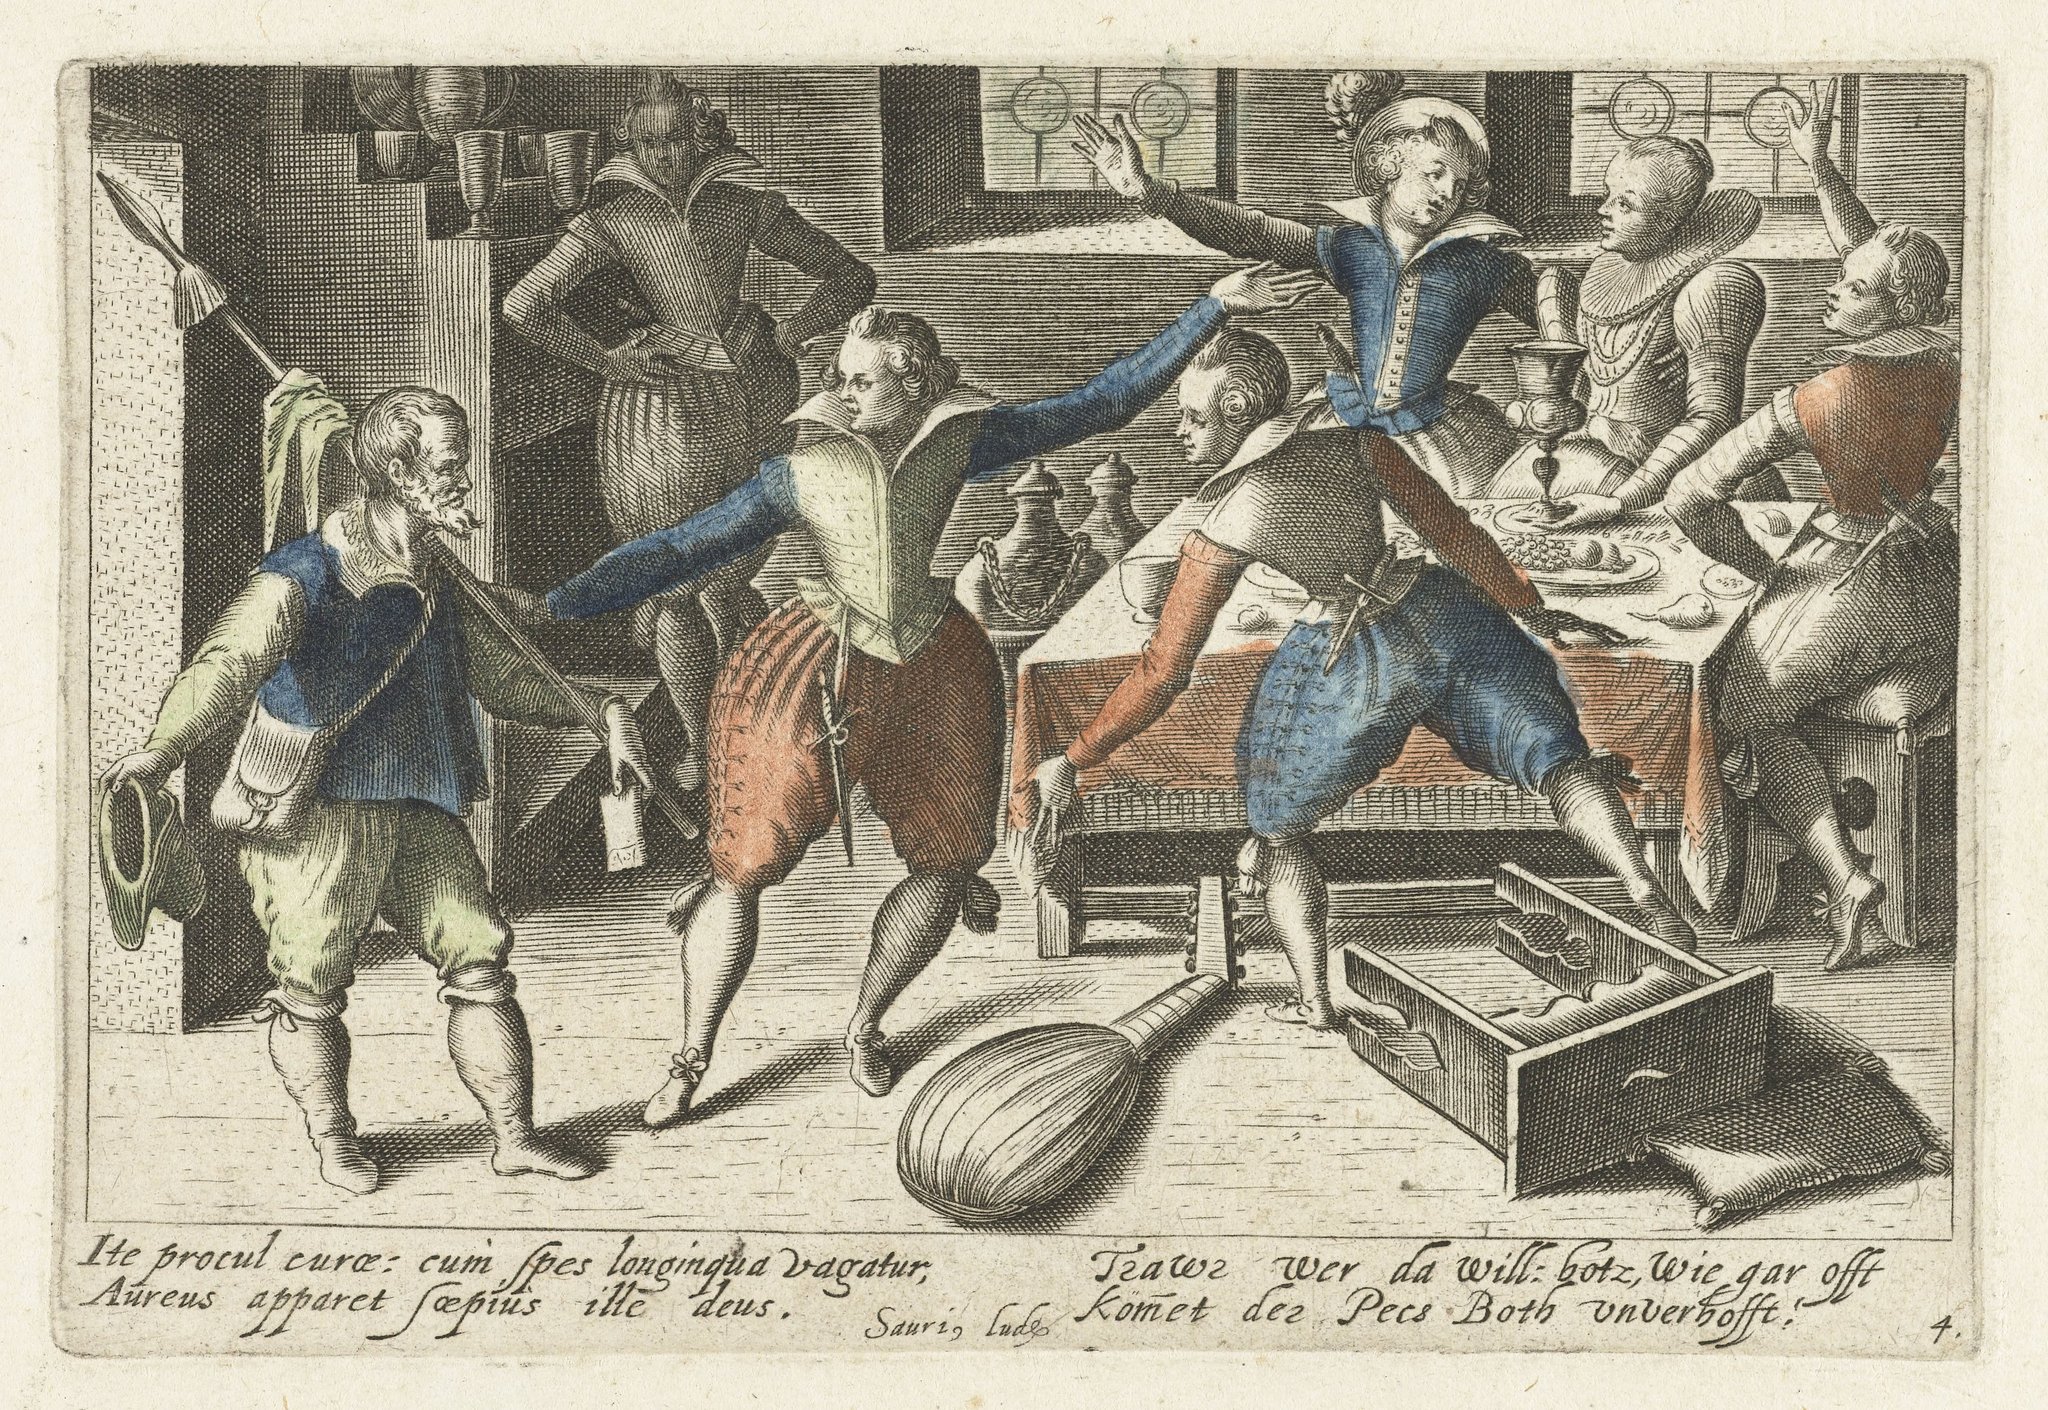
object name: print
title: Pugillus facetiarum iconographicarum in studiosorum (...)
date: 1608-1618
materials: paper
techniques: engraving, etching, hand coloring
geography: straatsburg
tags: 'album amicorum', 'stammbuch', beadle, lute, and special forms of lute, e.g.: theorbo, student life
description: Deze serie, getiteld ‘Pugillus facetiarum iconographicarum in studiosorum (…)’, bestond vermoedelijk uit 36 of meer prenten. Van deze serie zijn in ieder geval twee uitgaven bekend, uit 1608 en 1618. De prenten uit deze serie in de collectie van het Rijksmuseum (RP-P-1996-1 t/m RP-P-1996-36) zijn vermoedelijk afkomstig uit verschillende uitgaven, of uit de tweede uitgave. De inhoud van beide uitgaven verschilt, maar om de precieze inhoud van de verschillende uitgaven vast te stellen is meer onderzoek nodig. Er zijn geen volledige exemplaren van de eerste uitgave bekend. Aan de hand van de analyse van een andere serie, ‘Jeucht spieghel’,* die kopieën van ‘Pugillus’ bevat en is uitgegeven in 1610 én de aanwezige exemplaren van prenten uit ‘Pugillus’ in een inmiddels verloren album amicorum uit 1610,** kan in ieder geval van een aantal prenten gesteld worden dat ze al voorkwamen in de uitgave van 1608. Dit geldt voor RP-P-1996-1 (de titelprent), RP-P-1996-5, RP-P-1996-6, RP-P-1996-7, RP-P-1996-8, RP-P-1996-9, RP-P-1996-10, RP-P-1996-11, RP-P-1996-12, RP-P-1996-13, RP-P-1996-14, RP-P-1996-15, RP-P-1996-16, RP-P-1996-17, RP-P-1996-18, RP-P-1996-19, RP-P-1996-24, RP-P-1996-28, RP-P-1996-29, RP-P-1996-33 en RP-P-1996-35. Van één prent (RP-P-1996-31) kan vastgesteld worden dat die pas in de latere uitgave van 1618 voorkwam, omdat het kopie is van een prent uit weer een andere serie, ‘Academia sive speculum vitae scholasticae (…)’, die werd uitgegeven in 1612.*** Van de huidige prent is onduidelijk of hij al voorkwam in de uitgave van 1608. * Z.G.H.P.H.S [Zacharias Heyns]. Jeucht spieghel. S.l.s.n., 1610. Voor een gedigitaliseerd exemplaar zie: https://archive.org/details/ned-kbn-all-00000628-001/page/n9/mode/2up. ** Zie: Erman, Wilhelm en Ewald Horn. Bibliographie der deutschen Universitäten, systematisch geordnetes Verzeichnis der bis Ende 1899 gedruckten Bücher und Aufsätze über das deutsche Universitätswesen. Leipzig en Berlijn: Verlag von B.G. Teubner, 1904, dl. 1, p. 826-832, no. 17328. https://archive.org/details/bibliographieder01ermauoft/page/826/mode/2up *** Passe, Crispijn van de (I). Academia sive speculum vitae scholasticae (…). Arnhem: Johannes Janssonius [Jan Jansz.], 1612. Voor een gedigitaliseerd exemplaar zie: http://gallica.bnf.fr/ark:/12148/btv1b55005974h.